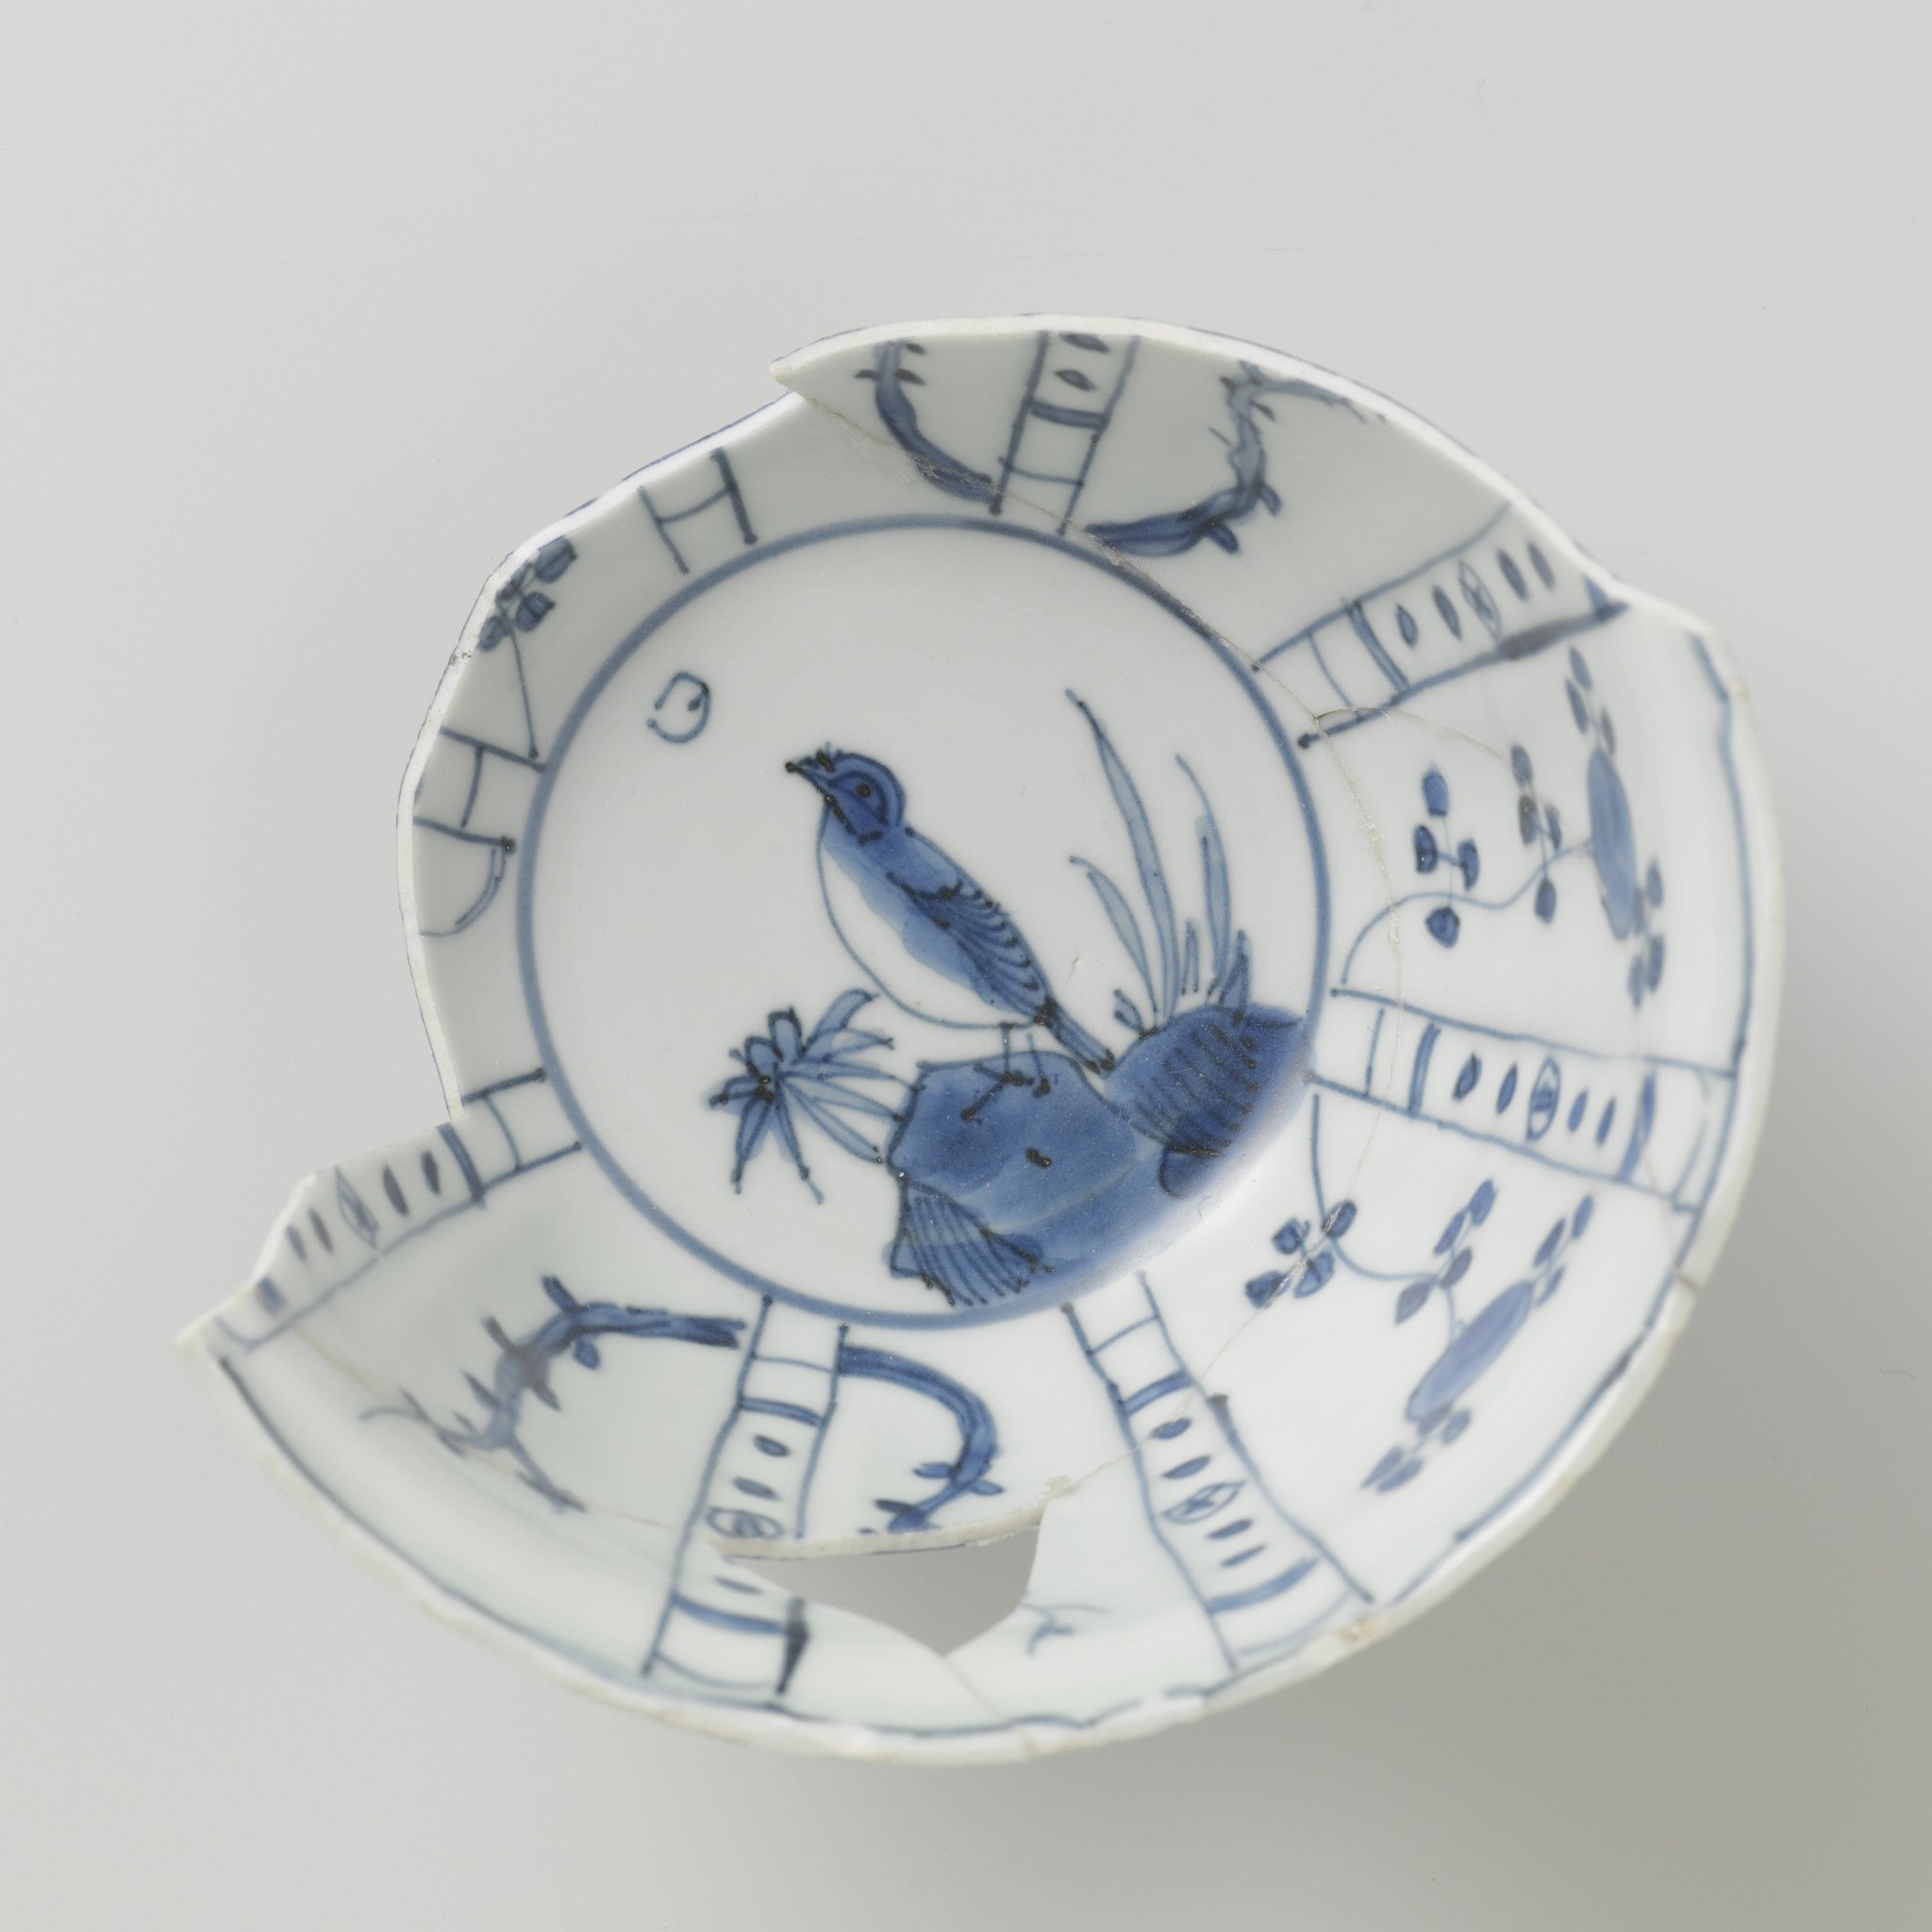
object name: kraaikop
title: Fragment kraaikop uit V.O.C.-schip de 'Witte Leeuw'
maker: Anonymous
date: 1613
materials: bone china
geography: jingdezhen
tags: verenigde oostindische compagnie, sint-helena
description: A high bowl. The interior panels decorated with peach-sprays and thorny branches. The outside with flowers, bamboo and a dragonfly.